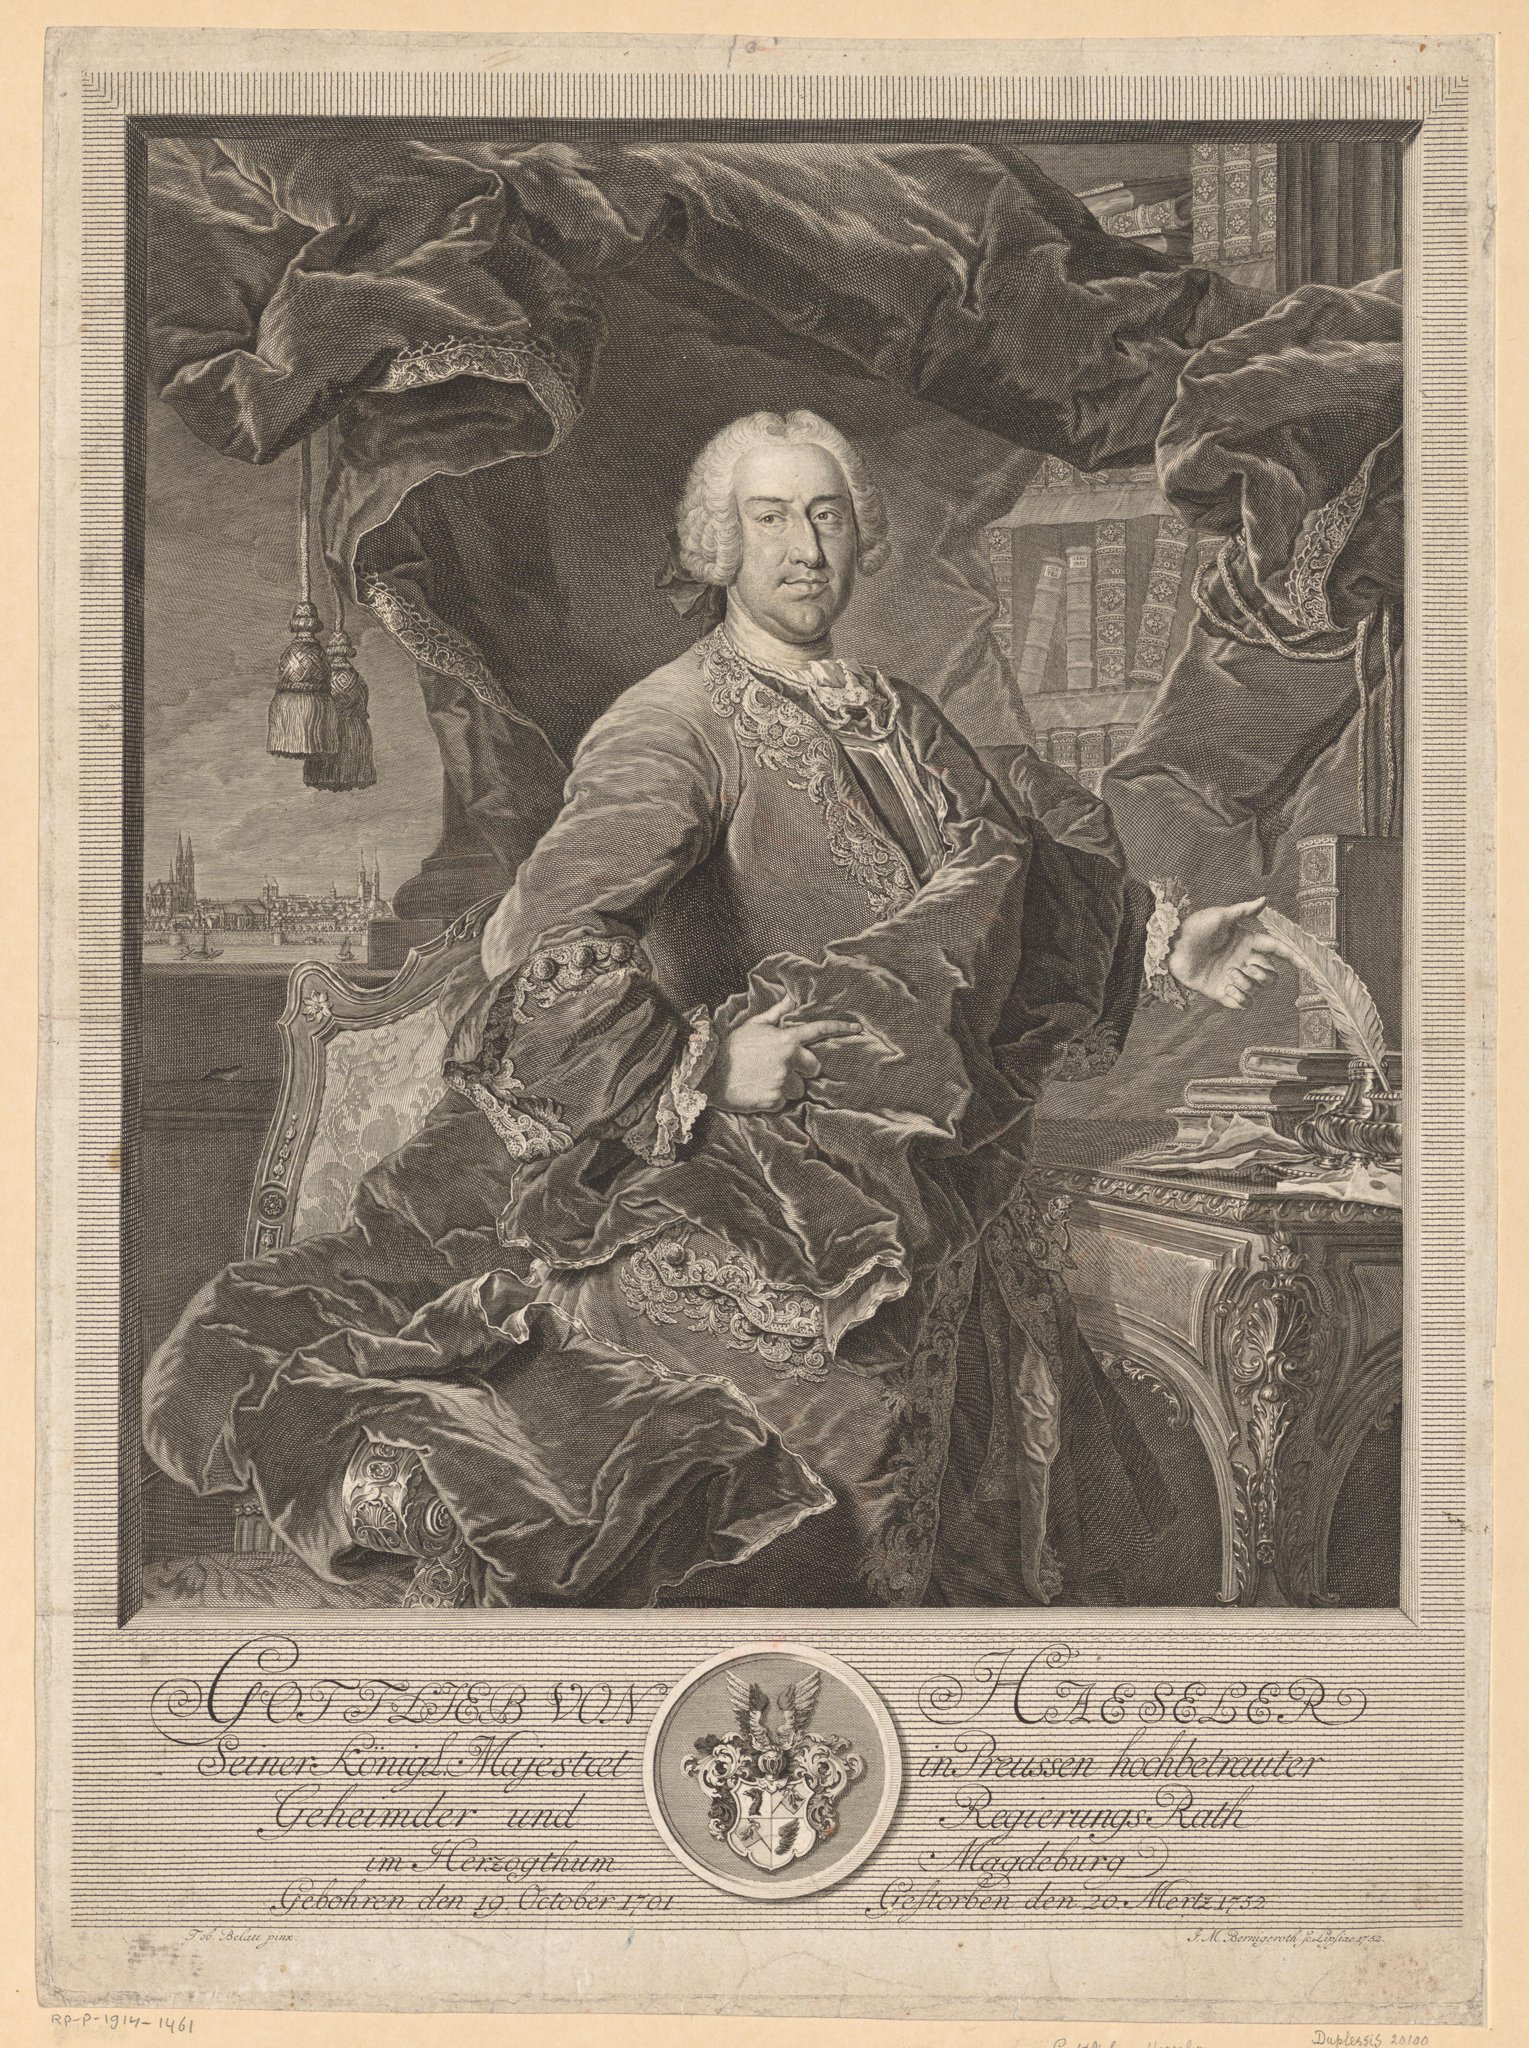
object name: print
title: Portret van Gottlieb von Haeseler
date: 1752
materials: paper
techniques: engraving, etching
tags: city-view in general; 'veduta', historical persons, book, armorial bearing, heraldry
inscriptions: date